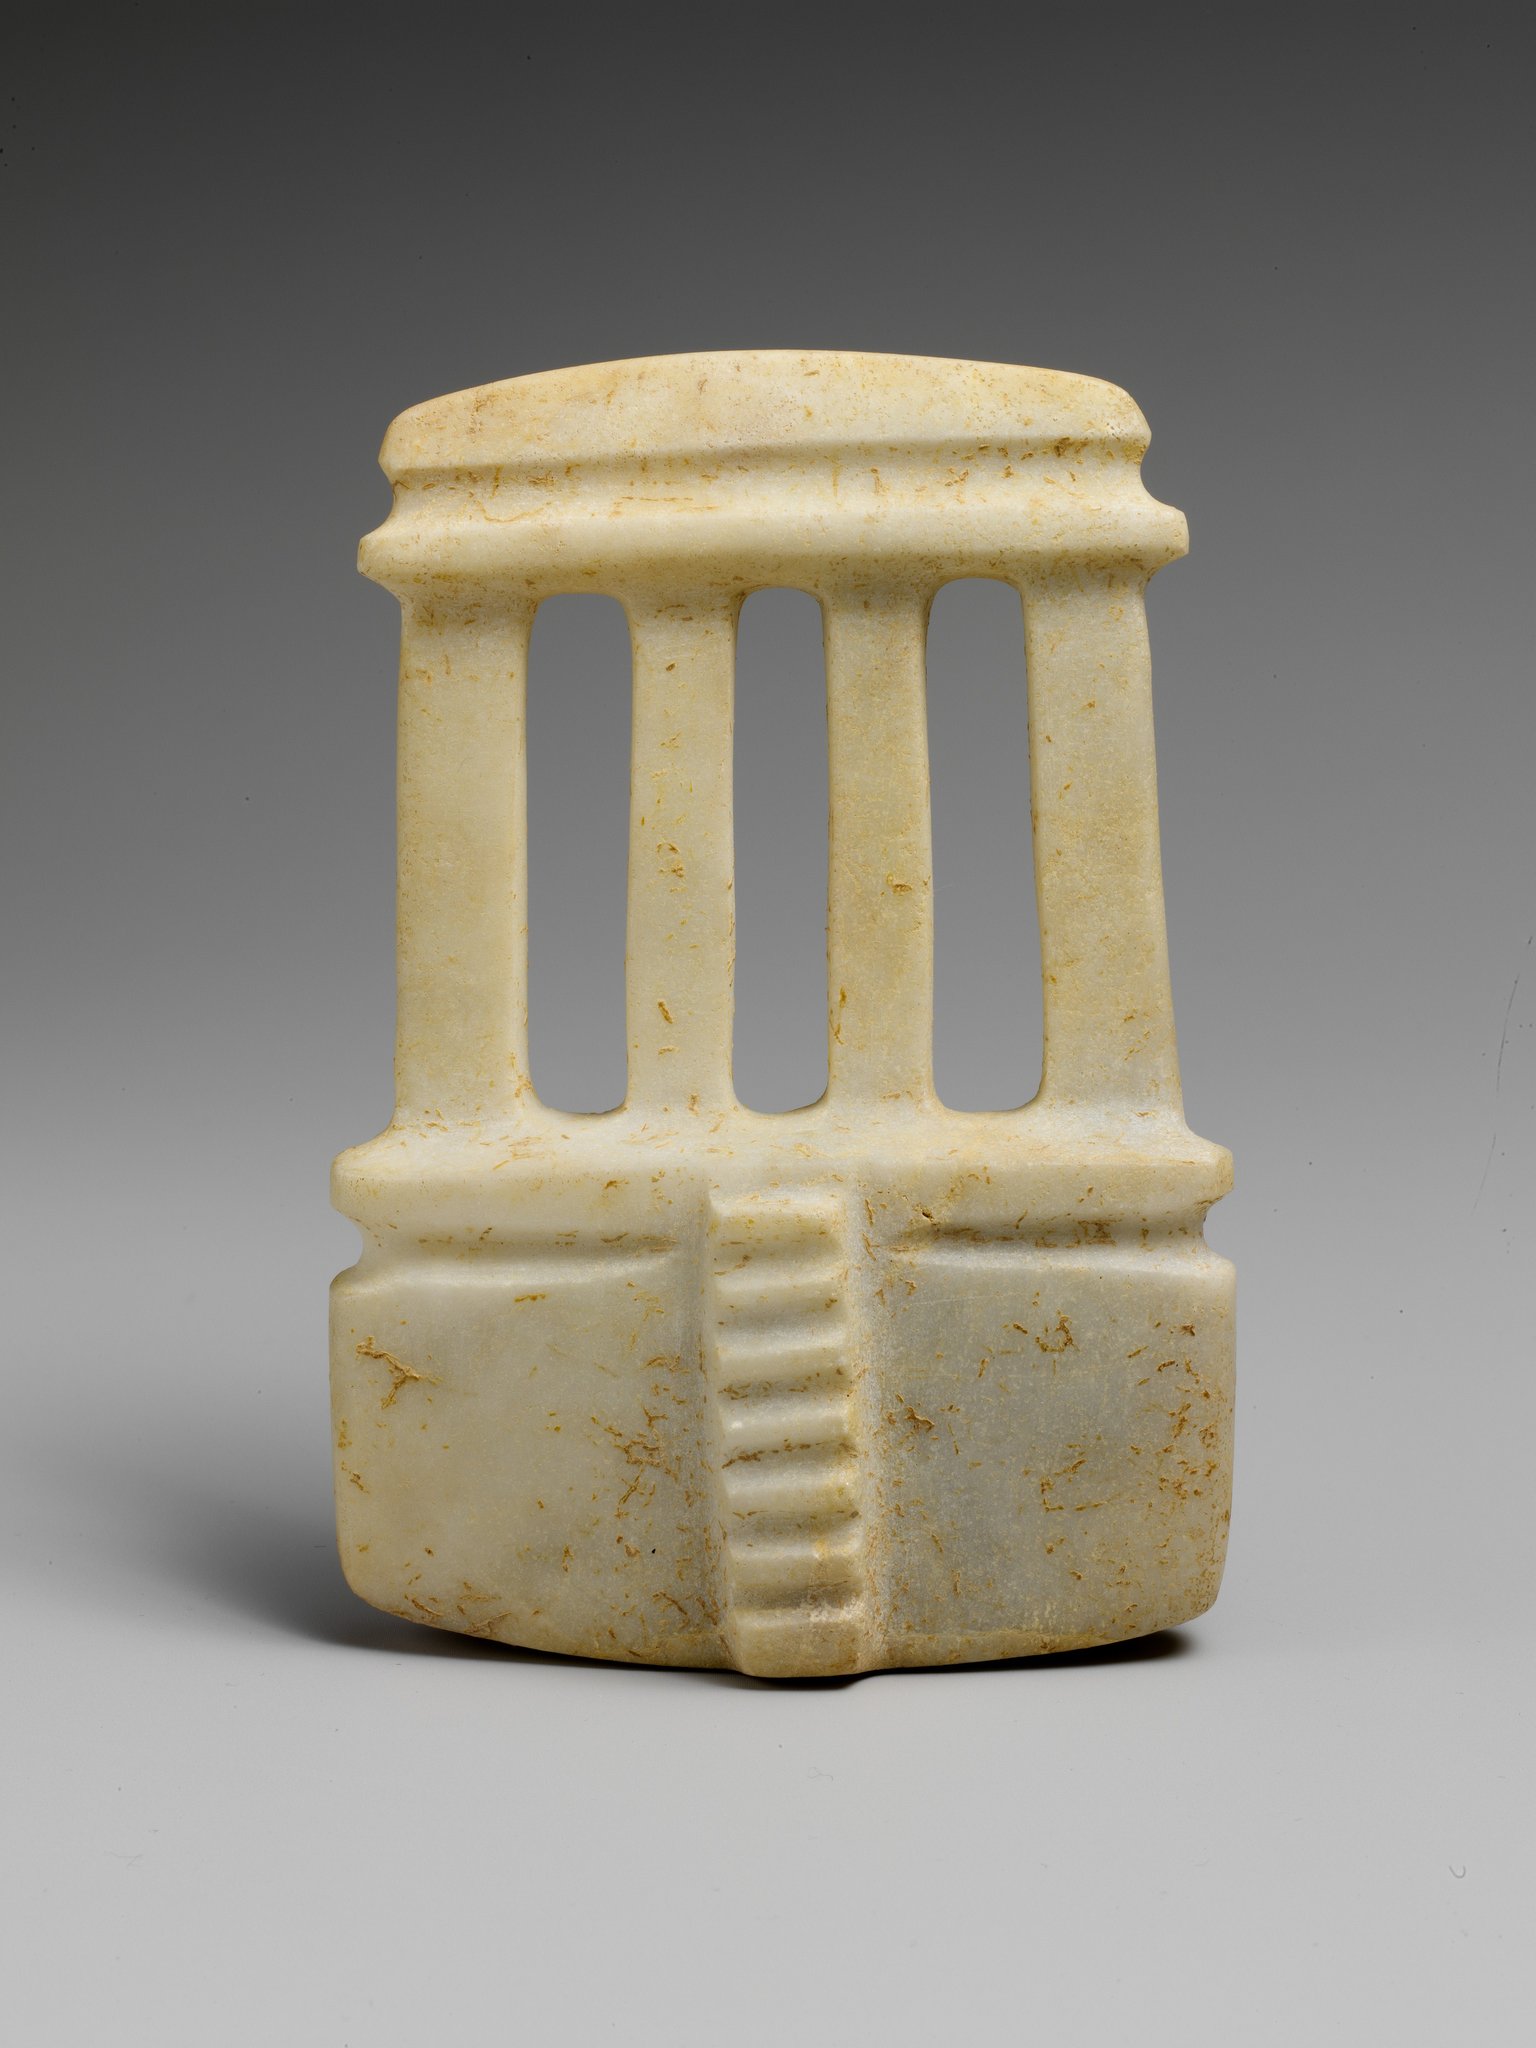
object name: architectural model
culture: mezcala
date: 1-800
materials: stone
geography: mexico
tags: temples